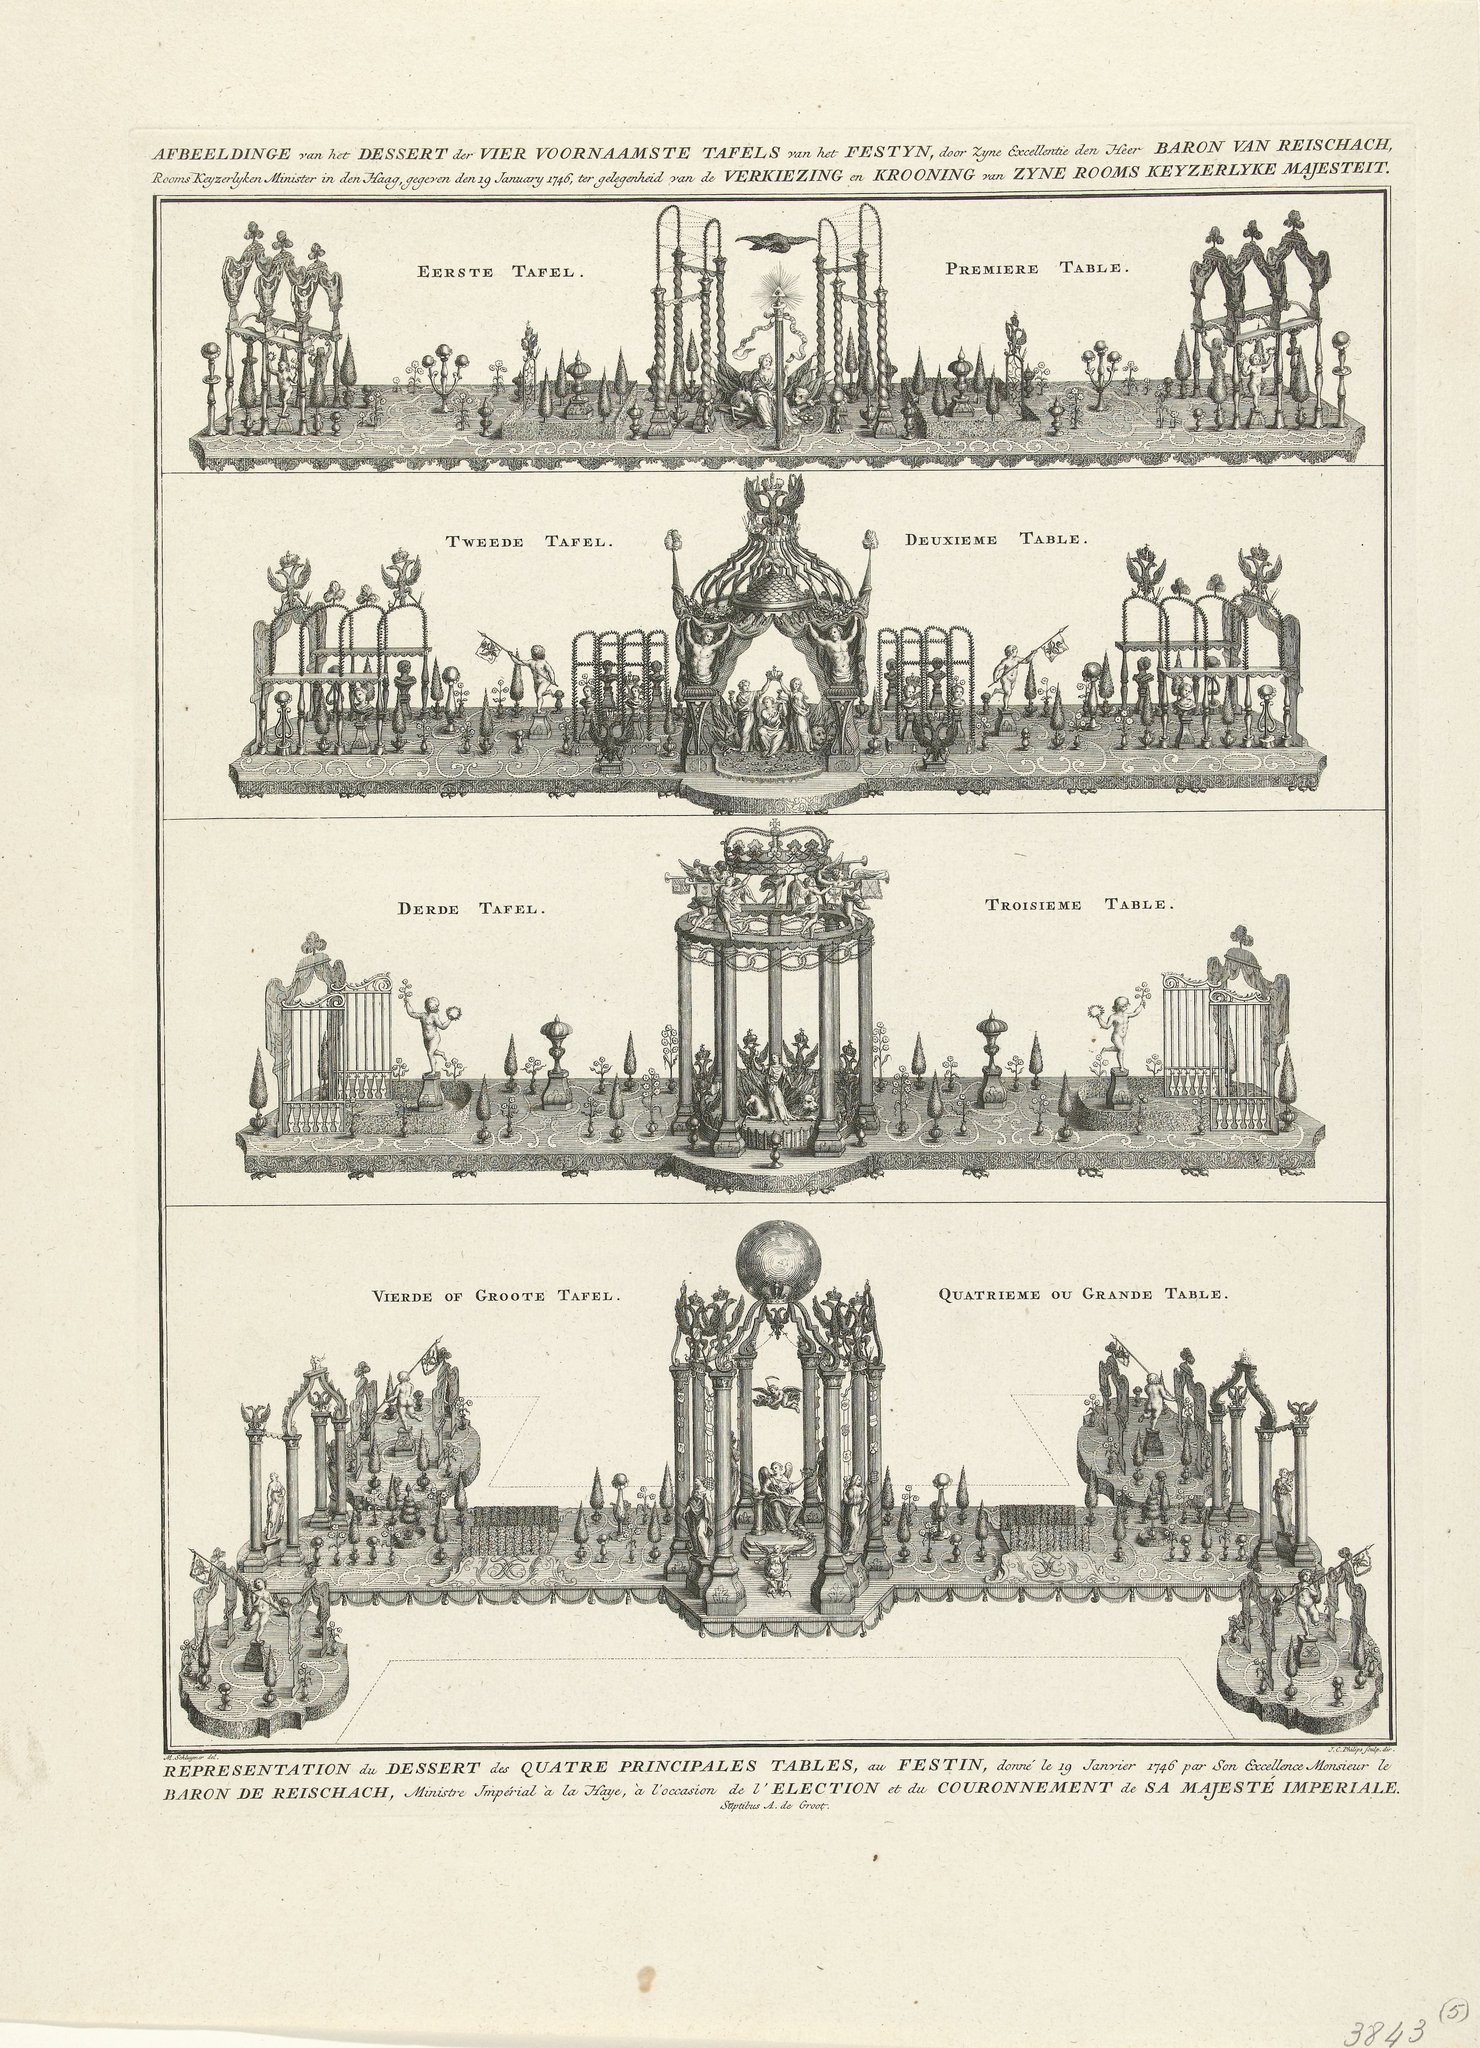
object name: print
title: Description des principales rejouissances, faites à la Haye, a l'occasion du couronnnement de (...) François I / Beschryving der voornaamste vreugde-bedryven in 's Gravenhage ter gelegenheid van de krooning van zyne keizerlyke majesteit Franciscus I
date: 1746-1747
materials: paper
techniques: engraving, etching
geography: northern netherlands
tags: frans i stefan (duits keizer), public festivities (+ eating and drinking ~ festive activities), coronation of a ruler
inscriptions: collector's mark: Lugt 2228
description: Het dessert zoals het gepresenteerd is op de vier voornaamste tafels tijdens het feestmaal gegeven door de Duitse minister en afgezant baron van Reischach in het Mauritshuis op 19 januari 1746 ter gelegenheid van de kroning van Frans I Stefan tot keizer op 4-6 oktober 1745. Tafelstukken in de vorm van vier ornamentele tuinen met zuilen, prieëlen, tempels, allegorische figuren en engelen.